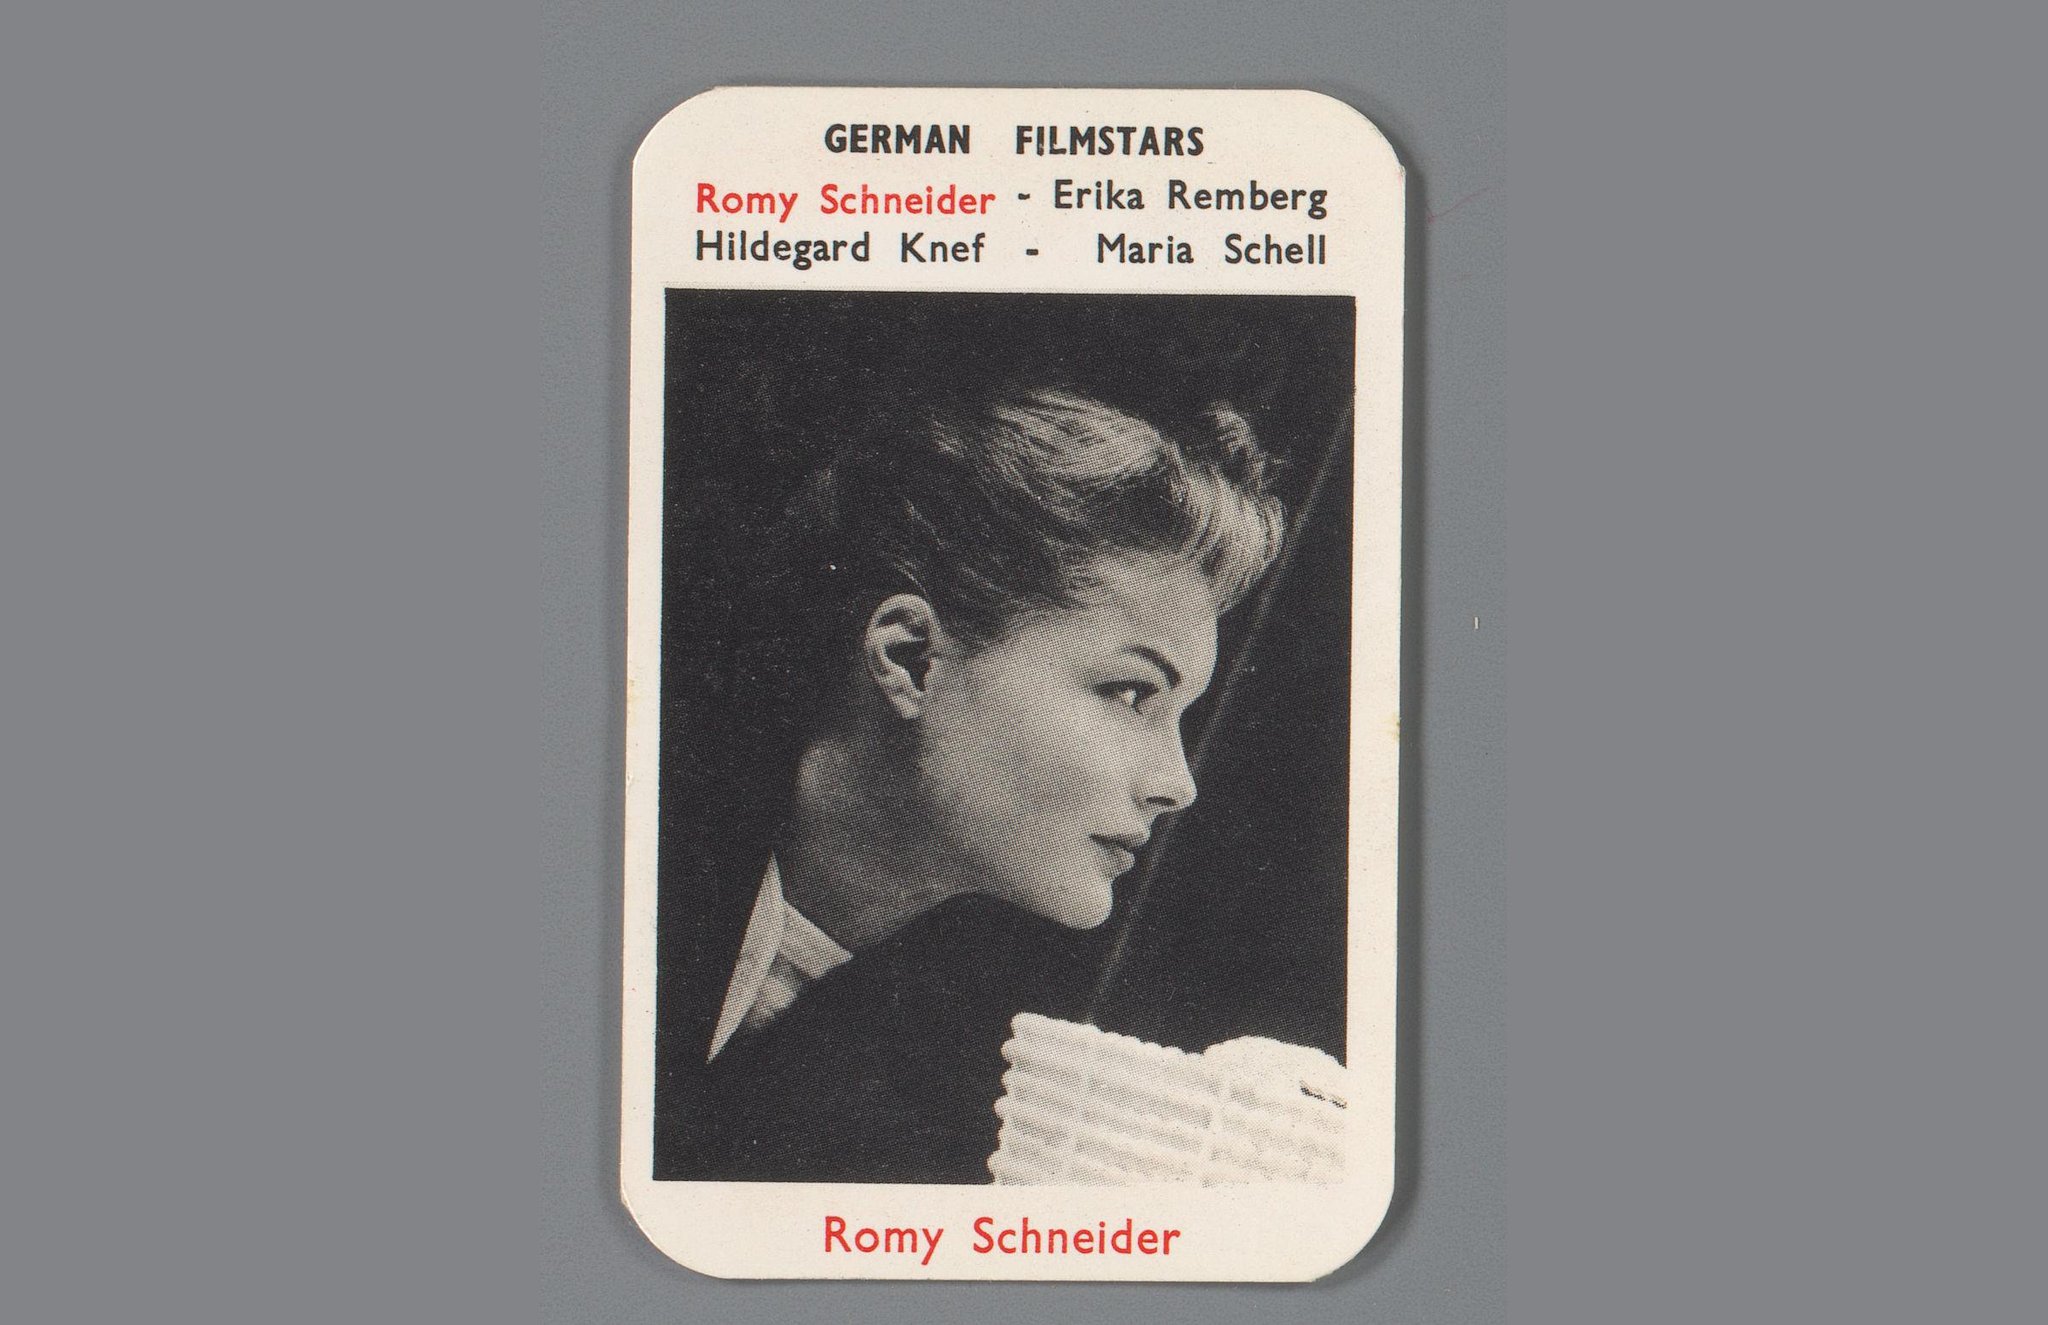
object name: playing card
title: German Filmstars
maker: Anonymous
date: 1960-1970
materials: paper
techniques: autotype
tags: portrait of actor, actress